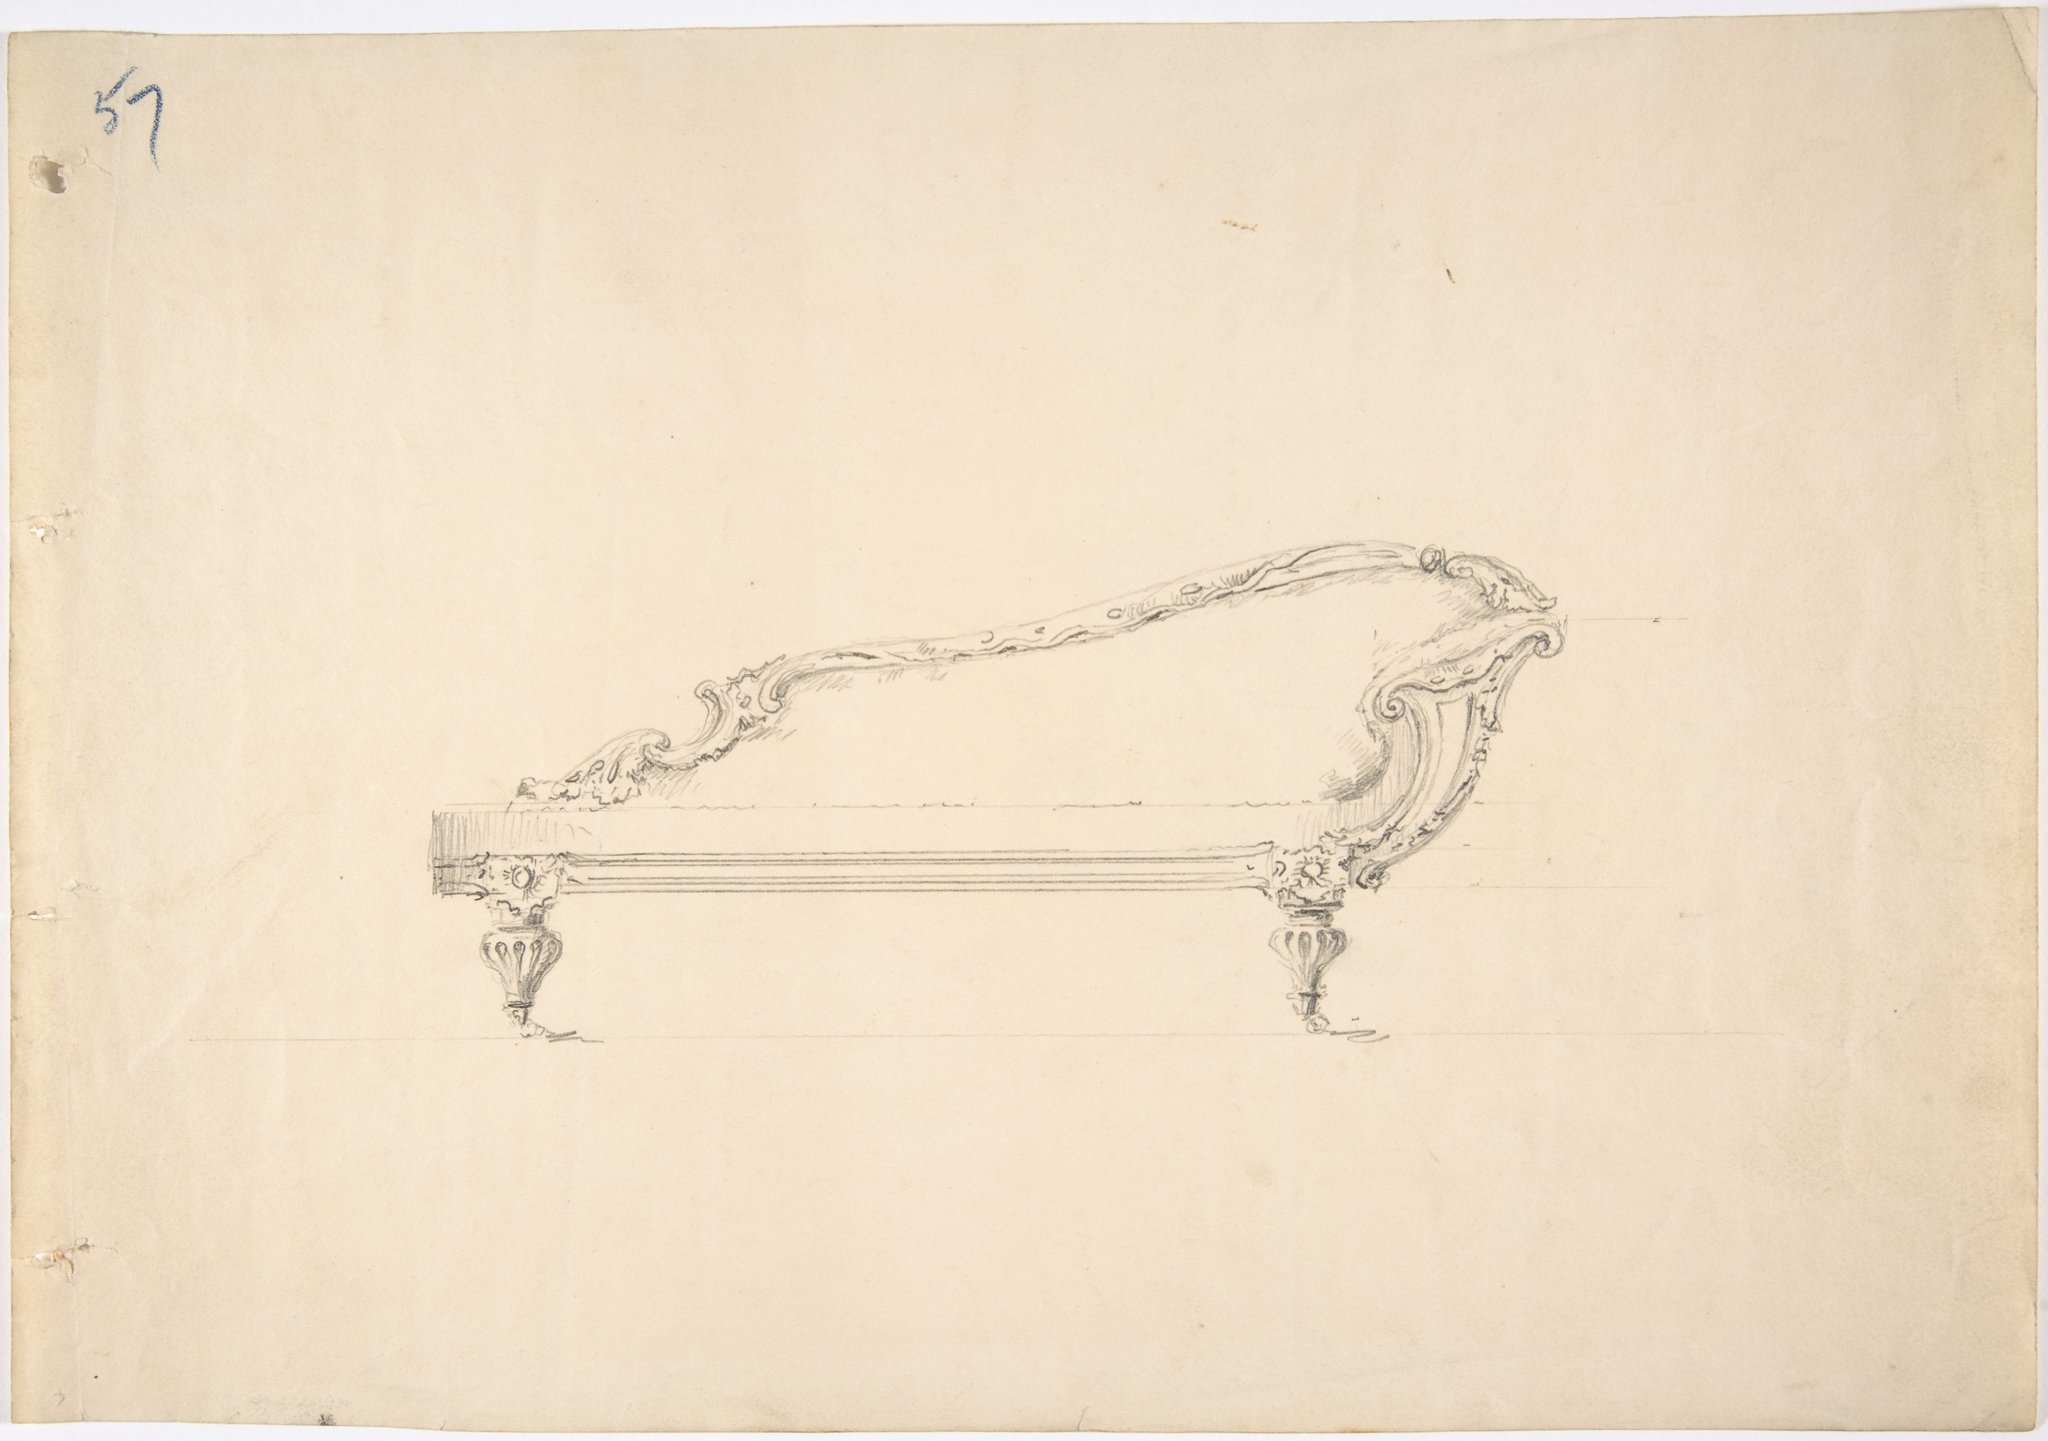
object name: drawing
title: Design for a One-armed Sofa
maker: anonymous, british, 19th century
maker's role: artist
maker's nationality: british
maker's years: 1800-1900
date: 1801-1833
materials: graphite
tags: couches